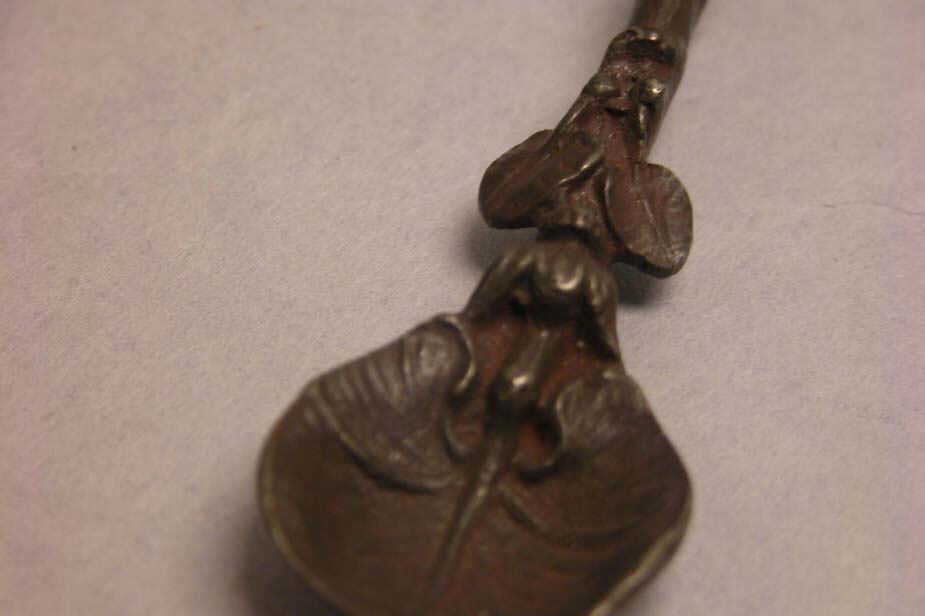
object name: spoon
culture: japanese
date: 1801-1900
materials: iron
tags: leaves